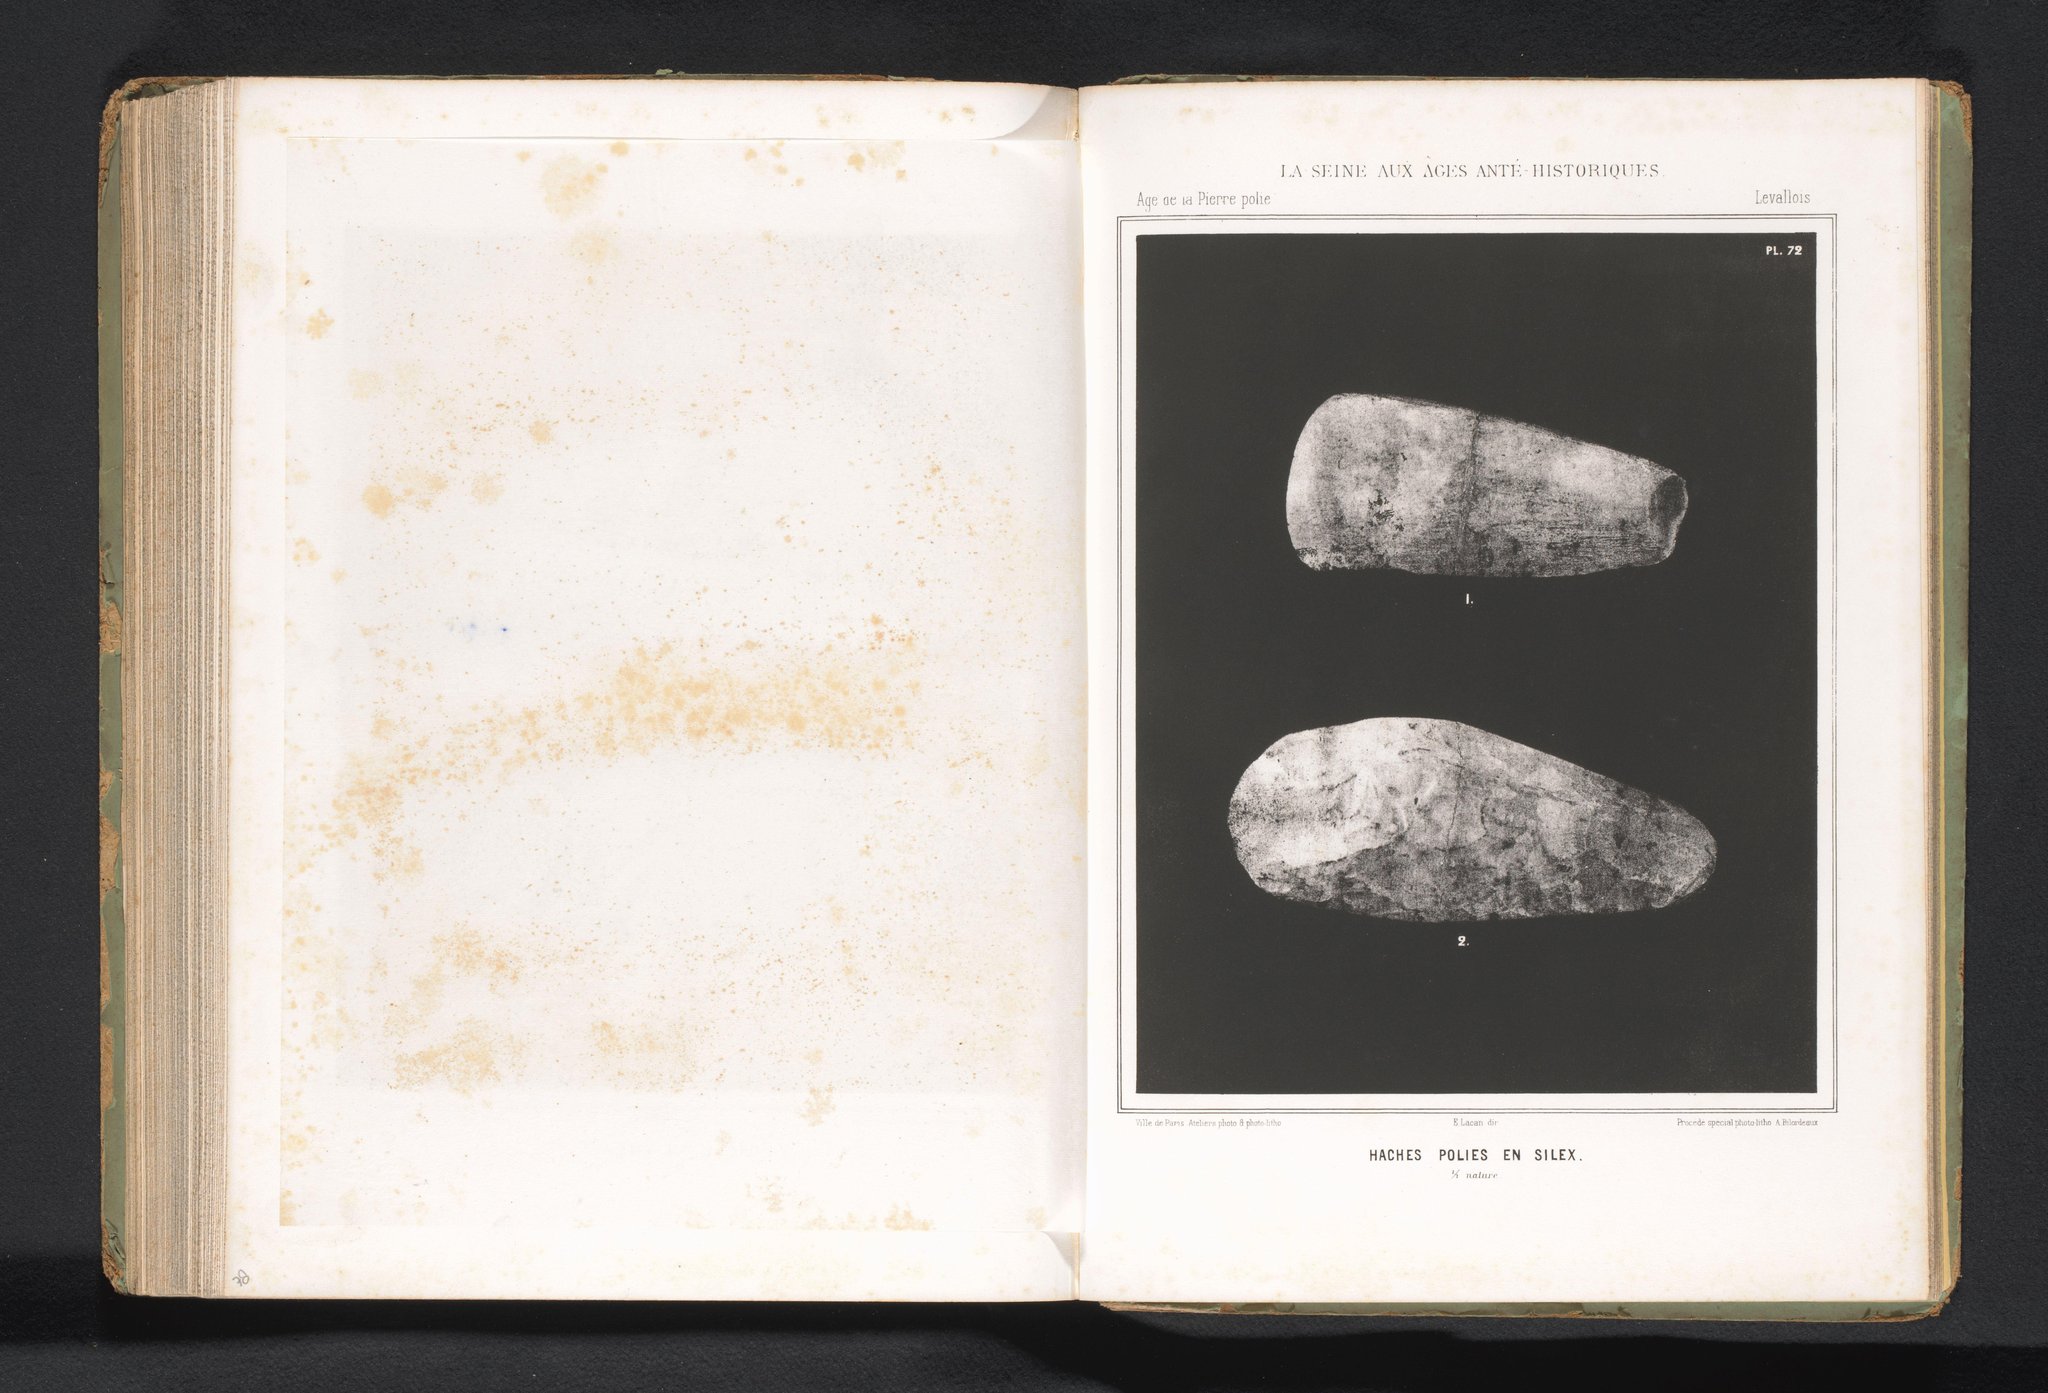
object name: page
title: Haches polies en silex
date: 1864-1869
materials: paper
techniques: photolithography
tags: tools, aids, implements ~ crafts and industries: axe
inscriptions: inscription: ‘1/1 nature’, inscription: ‘PL.72’, inscription: ‘Procédé spécial photo-litho. A. Bilordeaux’